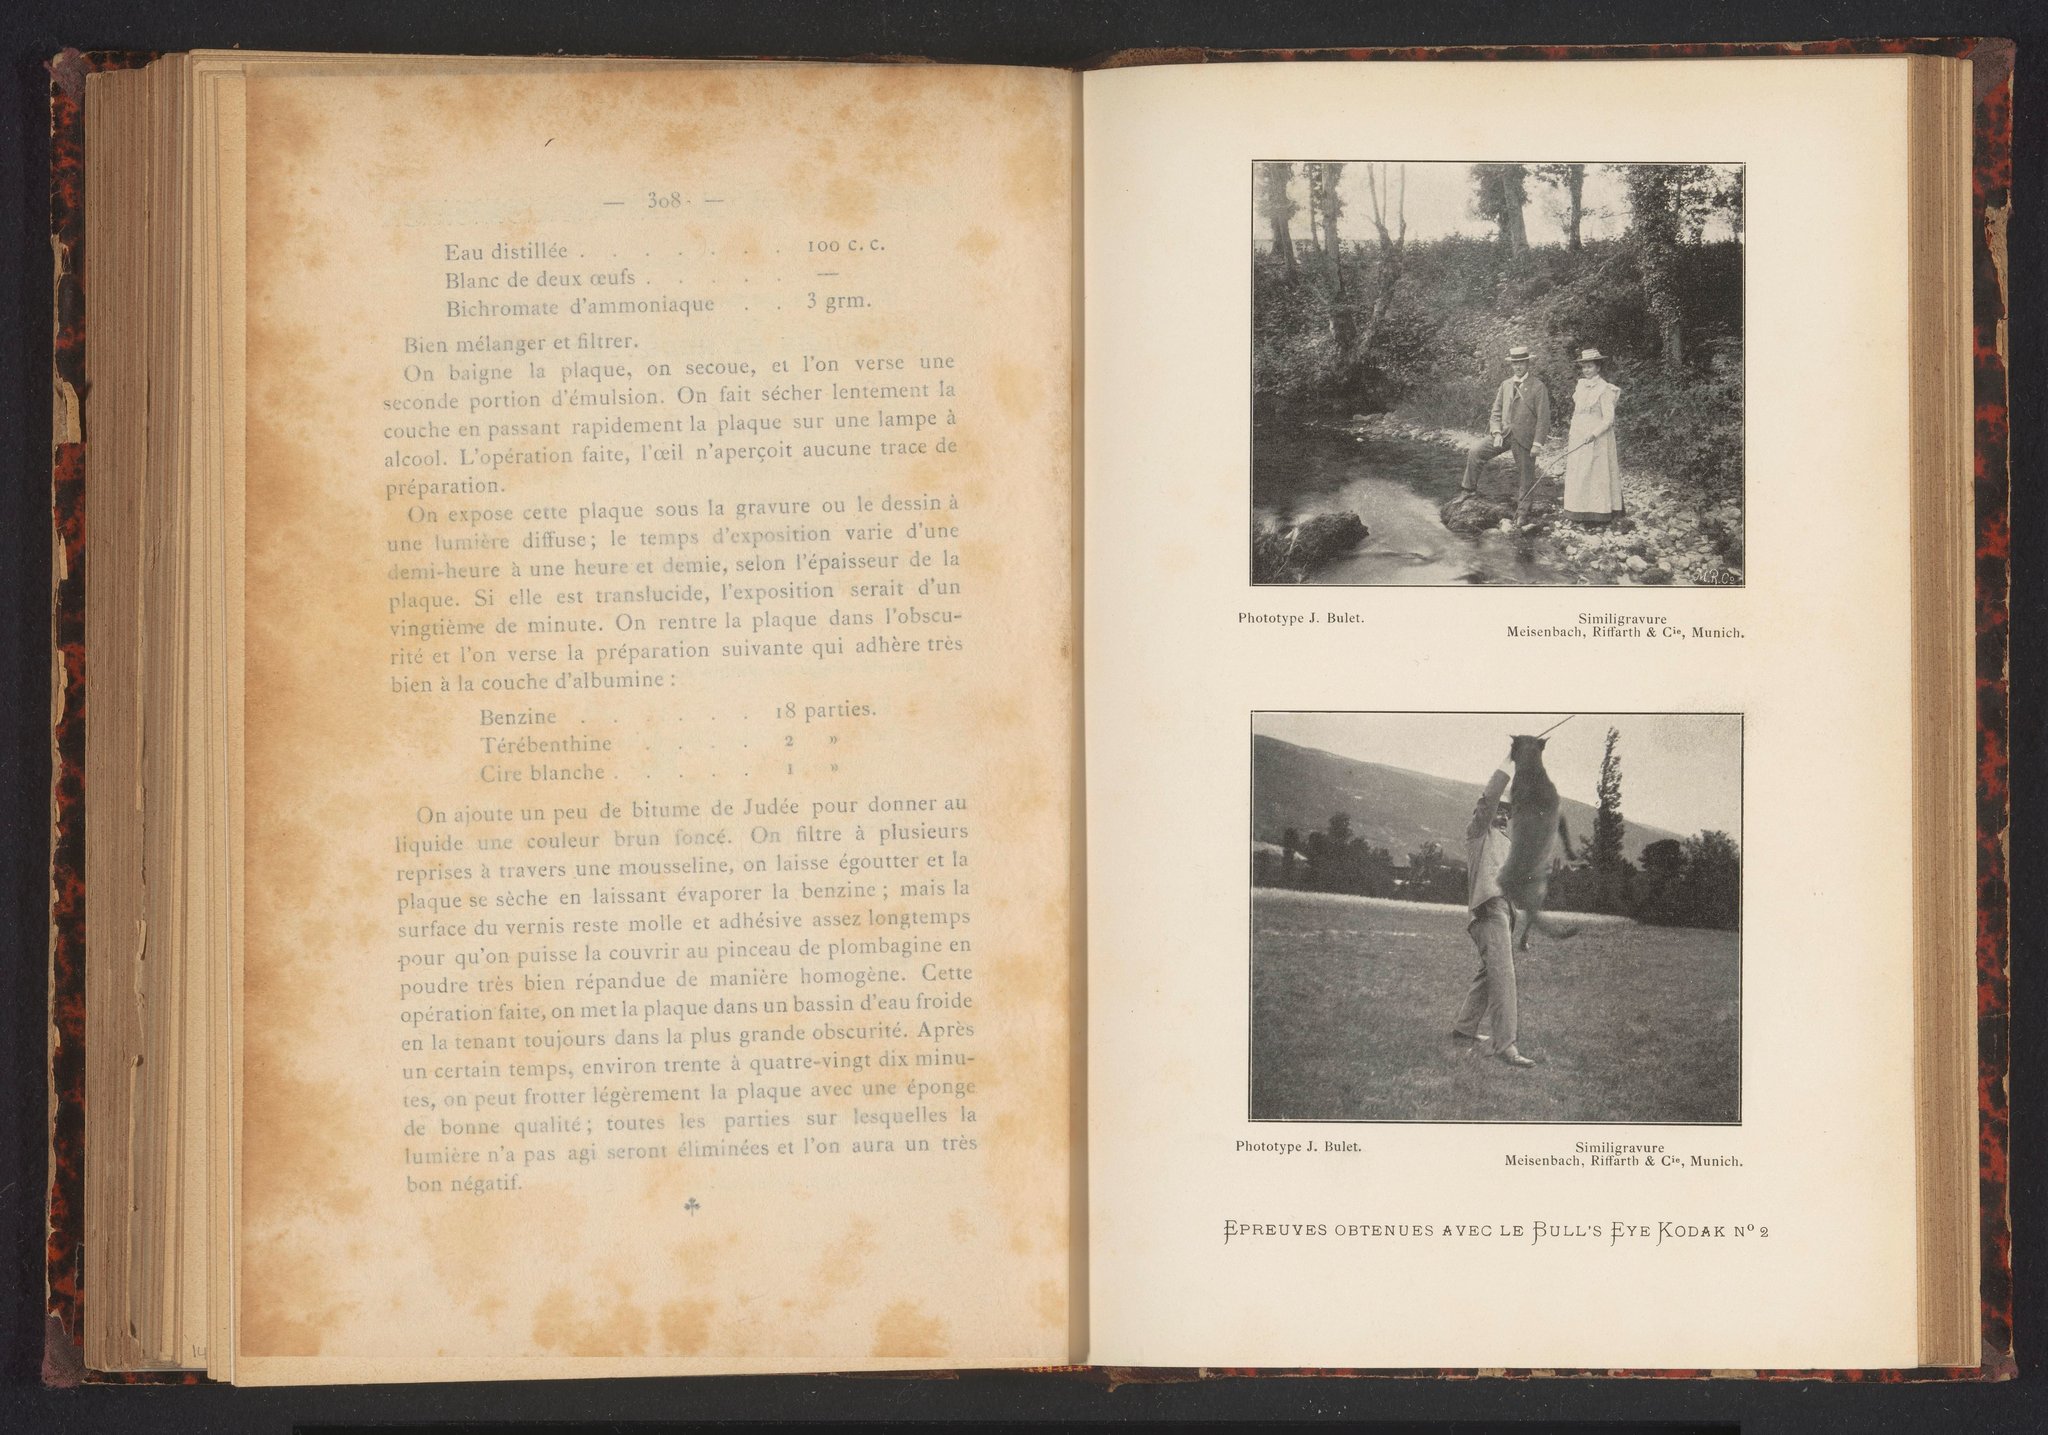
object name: page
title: Portret van een onbekende man en vrouw bij een rivier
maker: j. bulet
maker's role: fotograaf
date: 1895-1900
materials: paper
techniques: autotype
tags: river, historical persons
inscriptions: monogram: ‘M.R.Co’